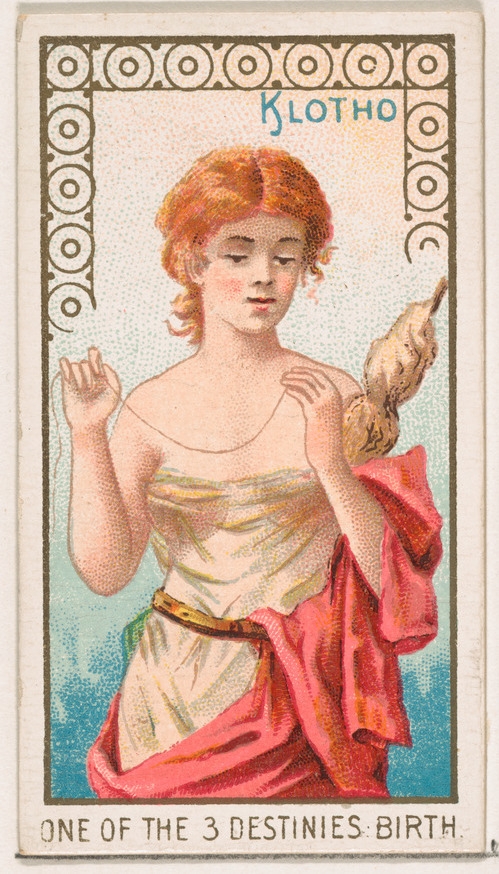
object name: print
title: Klotho, One of the Three Destinies, Birth, from the Goddesses of the Greeks and Romans series (N188) issued by Wm. S. Kimball & Co.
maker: william s. kimball & company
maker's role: publisher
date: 1889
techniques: color lithograph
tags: goddess